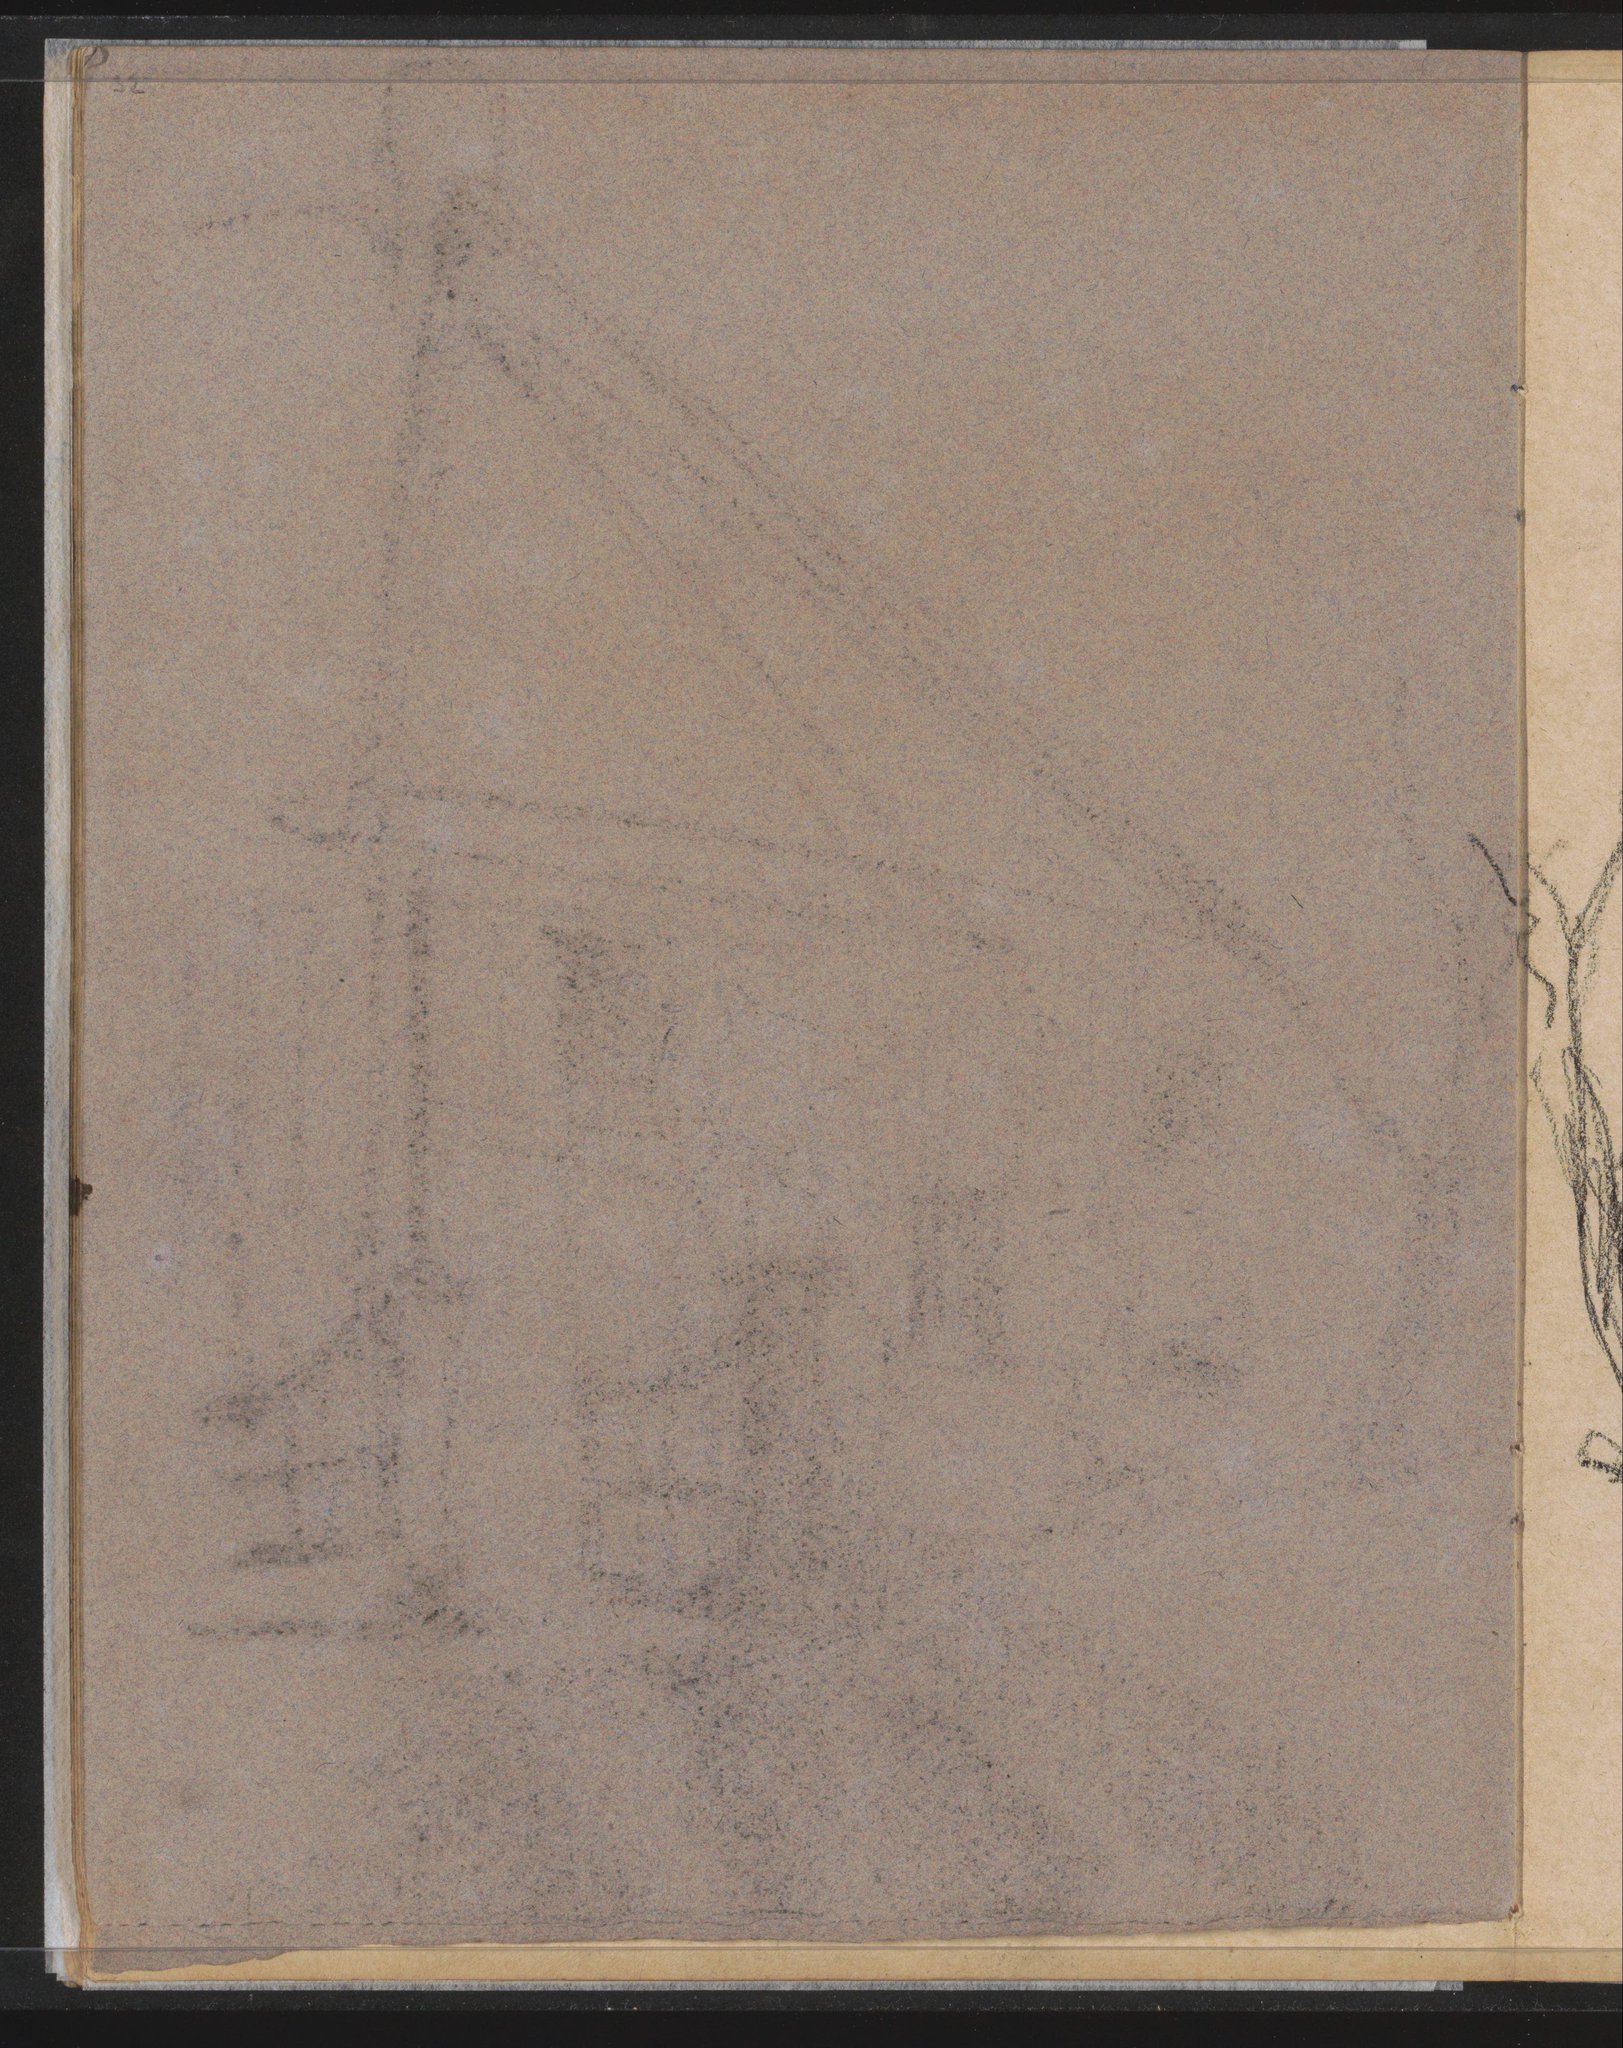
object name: sketchbook leaf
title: Abklatsch van de krijttekening op pagina 33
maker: willem witsen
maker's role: draughtsman, painter, print maker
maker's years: 1860-1923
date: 1887-1888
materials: paper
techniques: printmaking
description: Pagina 32 uit een schetsboek met 43 bladen.